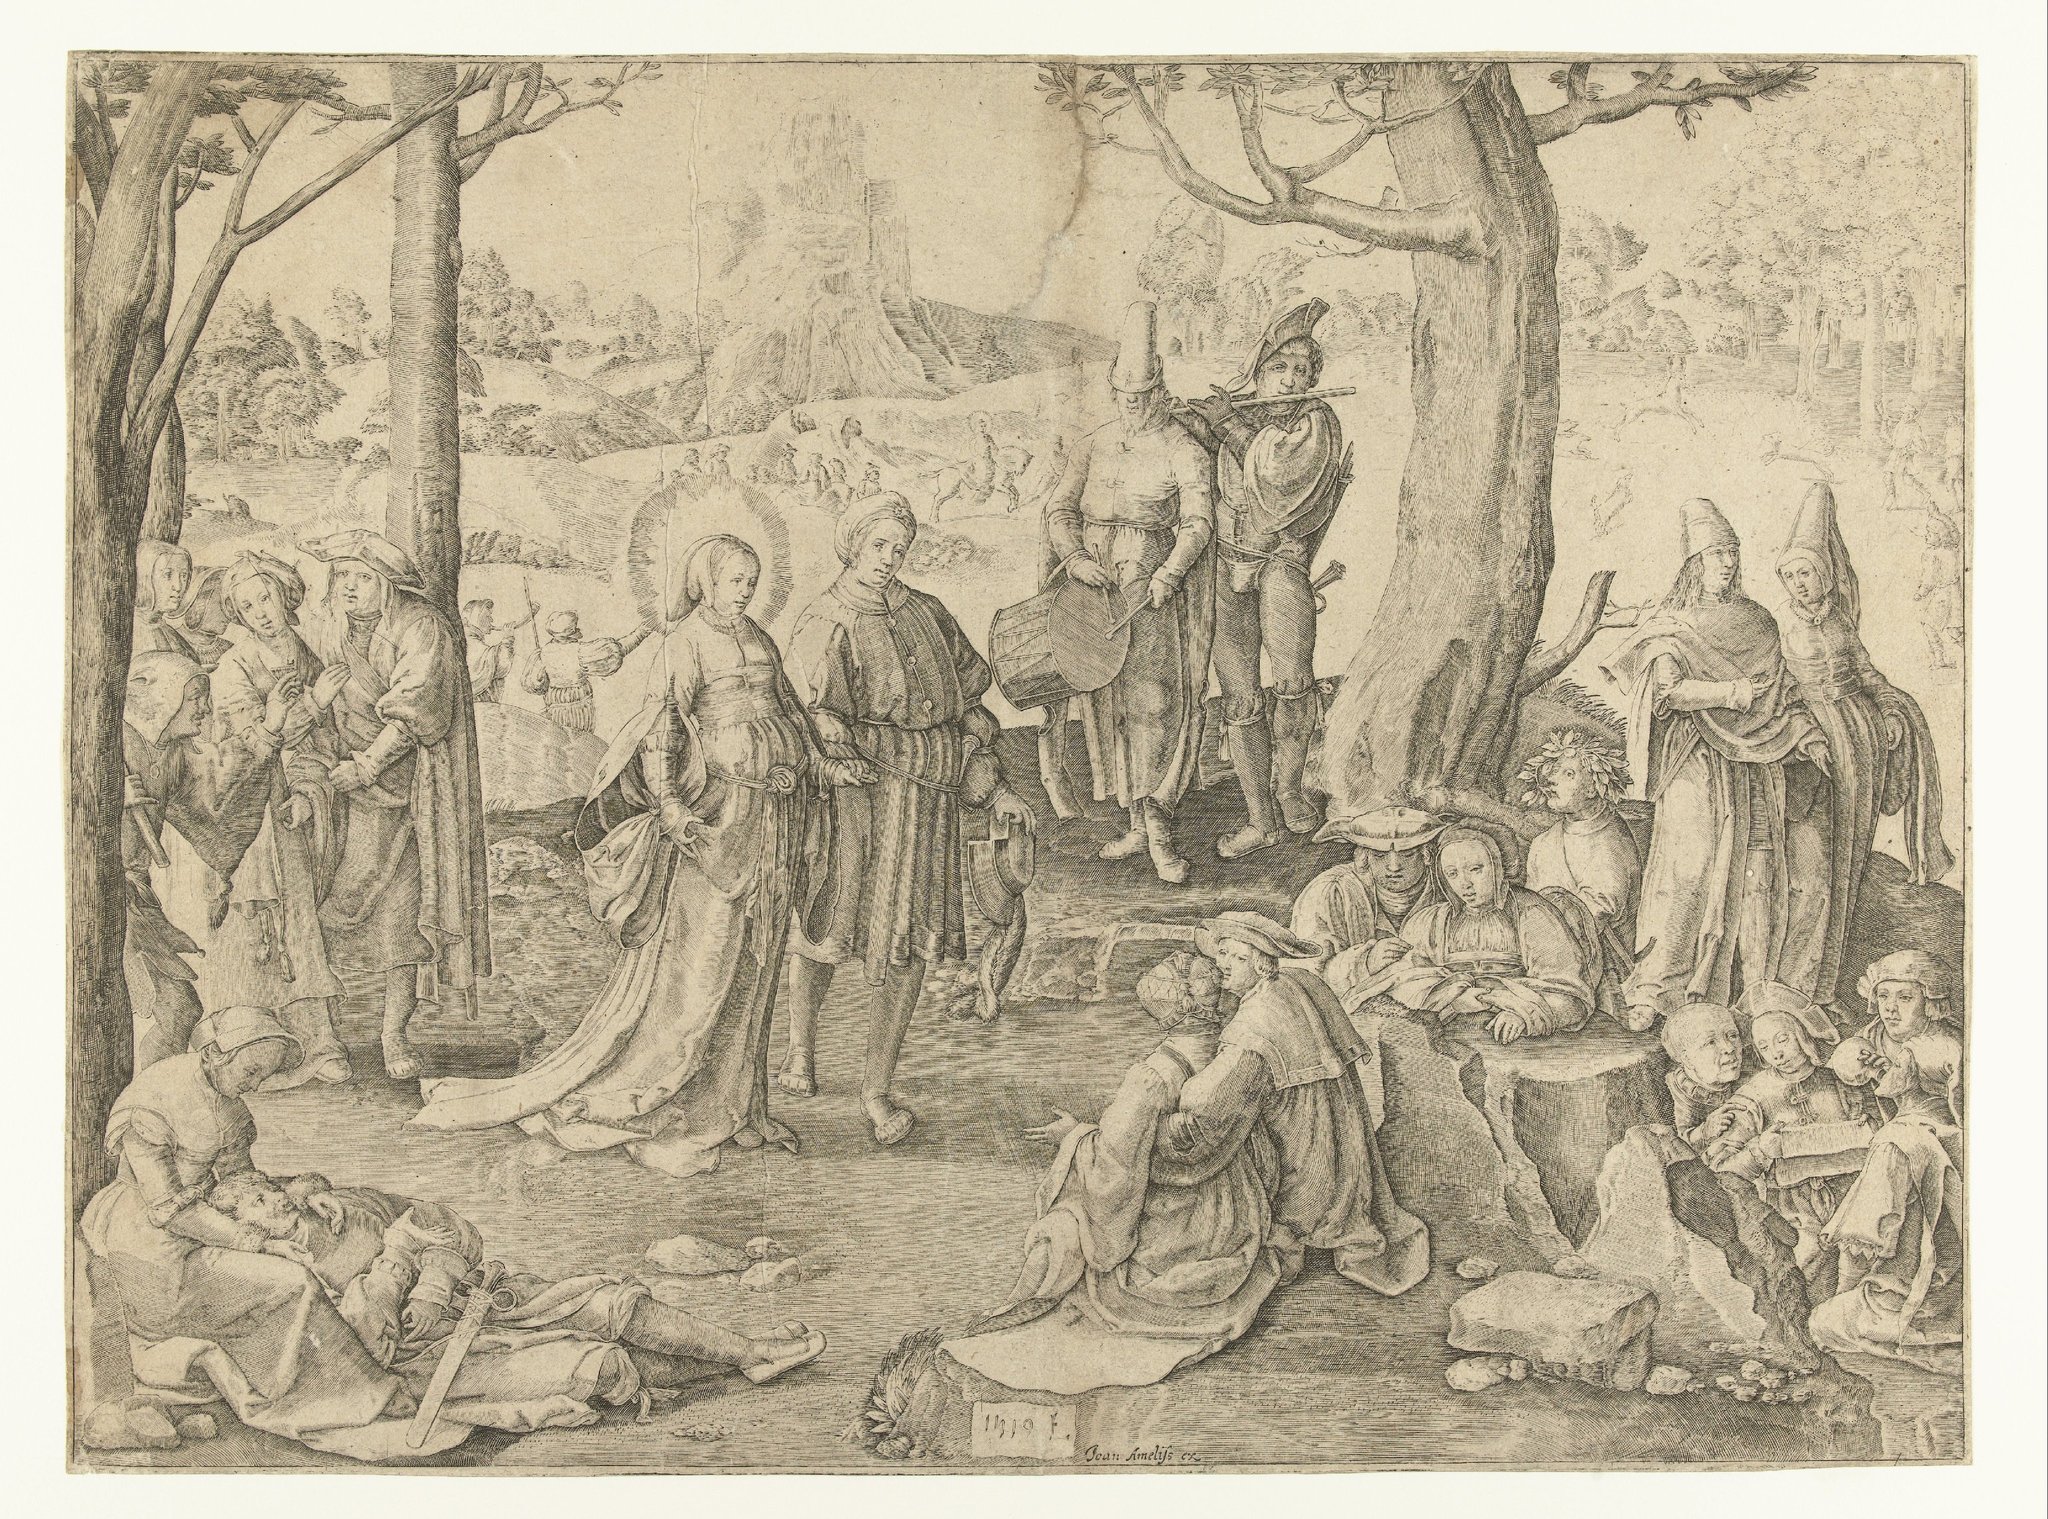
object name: print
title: De dans van Maria Magdalena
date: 1606-1636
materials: paper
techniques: engraving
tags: the penitent st. mary magdalene (often before a cave, possibly at la sainte-baume hill): her long hair covers her (naked) body, she reads, meditates or raises her tear-filled eyes towards heaven, life of st. mary magdalene before her conversion, e.g. dancing, hunting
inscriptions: collector's mark: Lugt 240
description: In een landschap danst Maria Magdalena met een man op de muziek van een fluitspeler en trommelaar. In landschap op de achtergrond Maria Magdalena te paard aan het jagen.